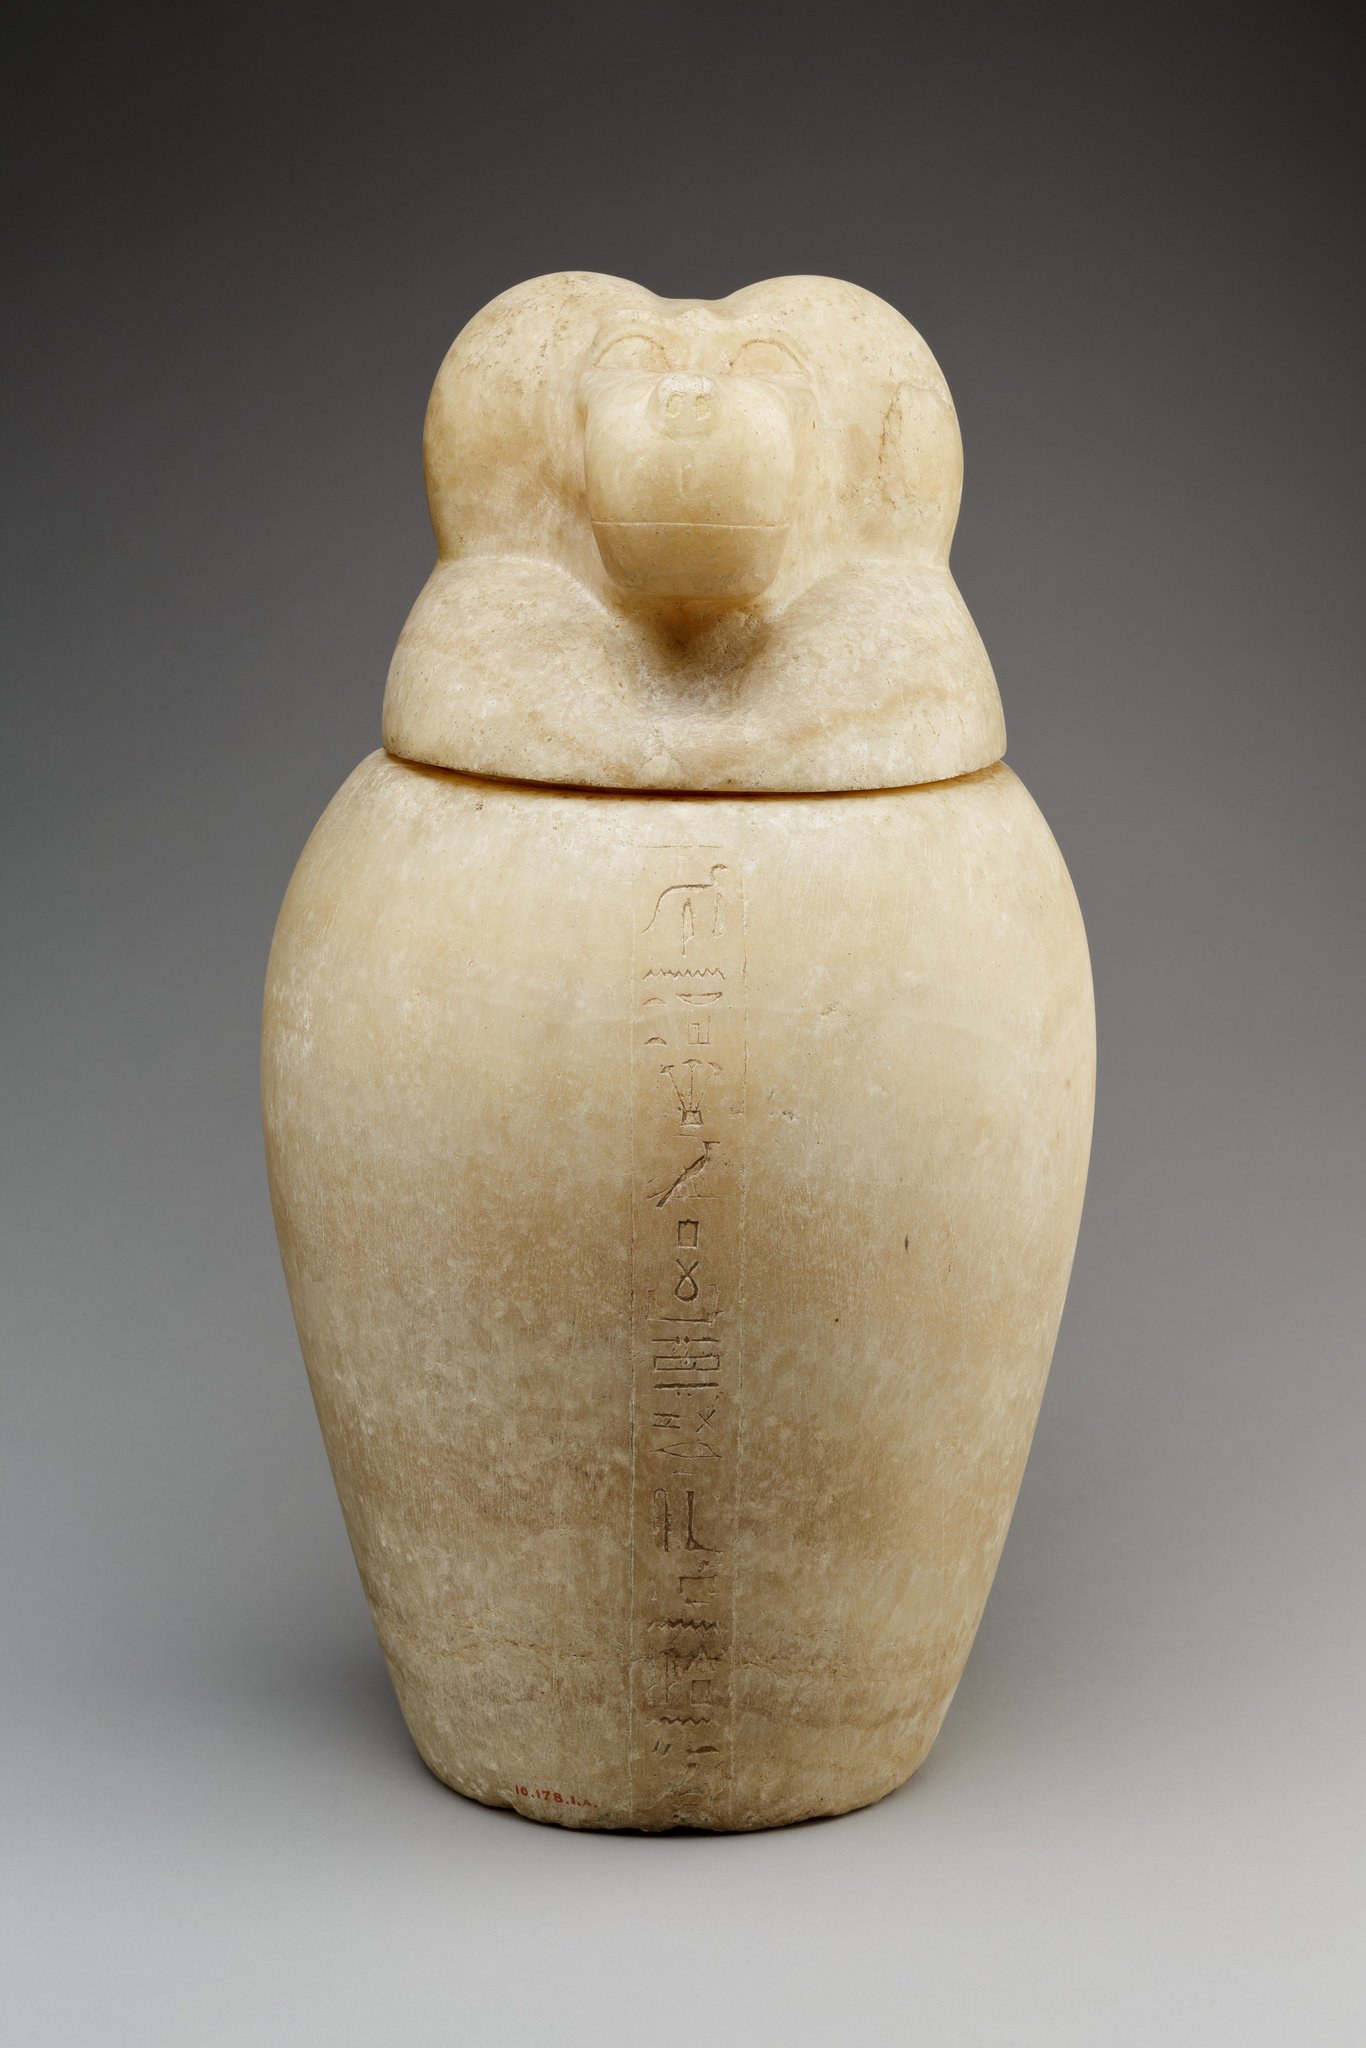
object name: canopic jar, baboon, hapy, nephthys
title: Canopic jar with a baboon-headed lid (Hapy)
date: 664-525 BCE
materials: stone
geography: egypt